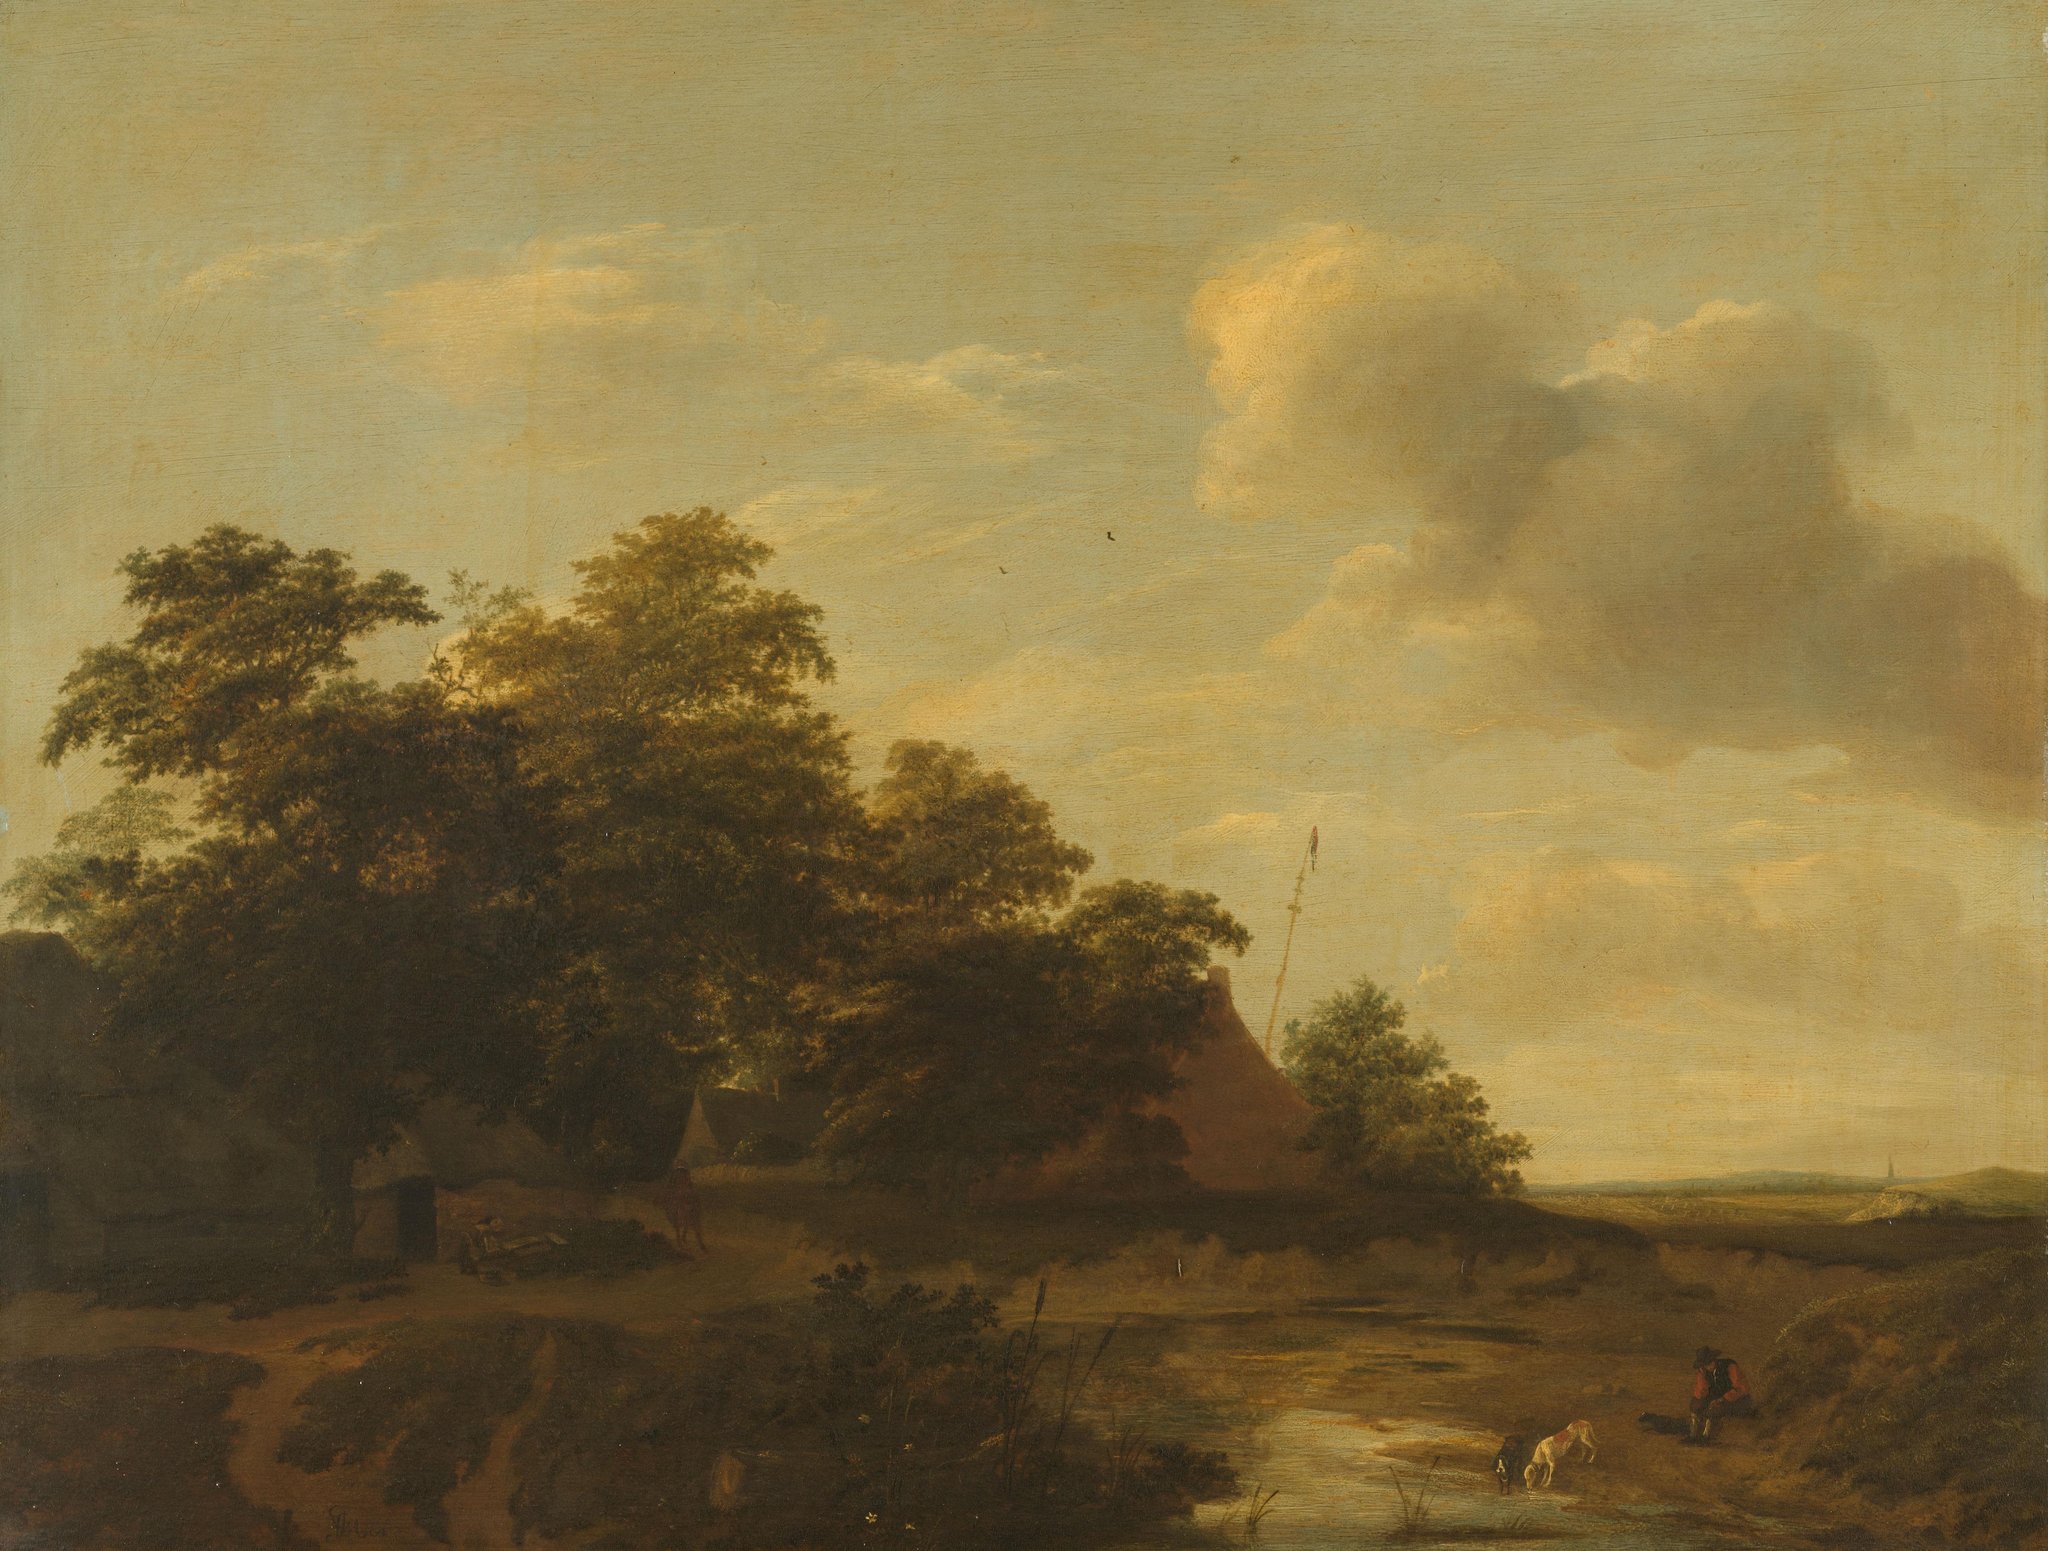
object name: painting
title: Landscape with a Farm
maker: jan vermeer van haarlem (i)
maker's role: painter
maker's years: 1628-1691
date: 1648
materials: oil, panel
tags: farm or solitary house in landscape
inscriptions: signature: ‘JVMeer’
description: Landschap met boerderij en schuur onder bomen, rechts een zittende man met een honden die uit een waterplas drinken. Pendant van een schilderij in het Mauritshuis.